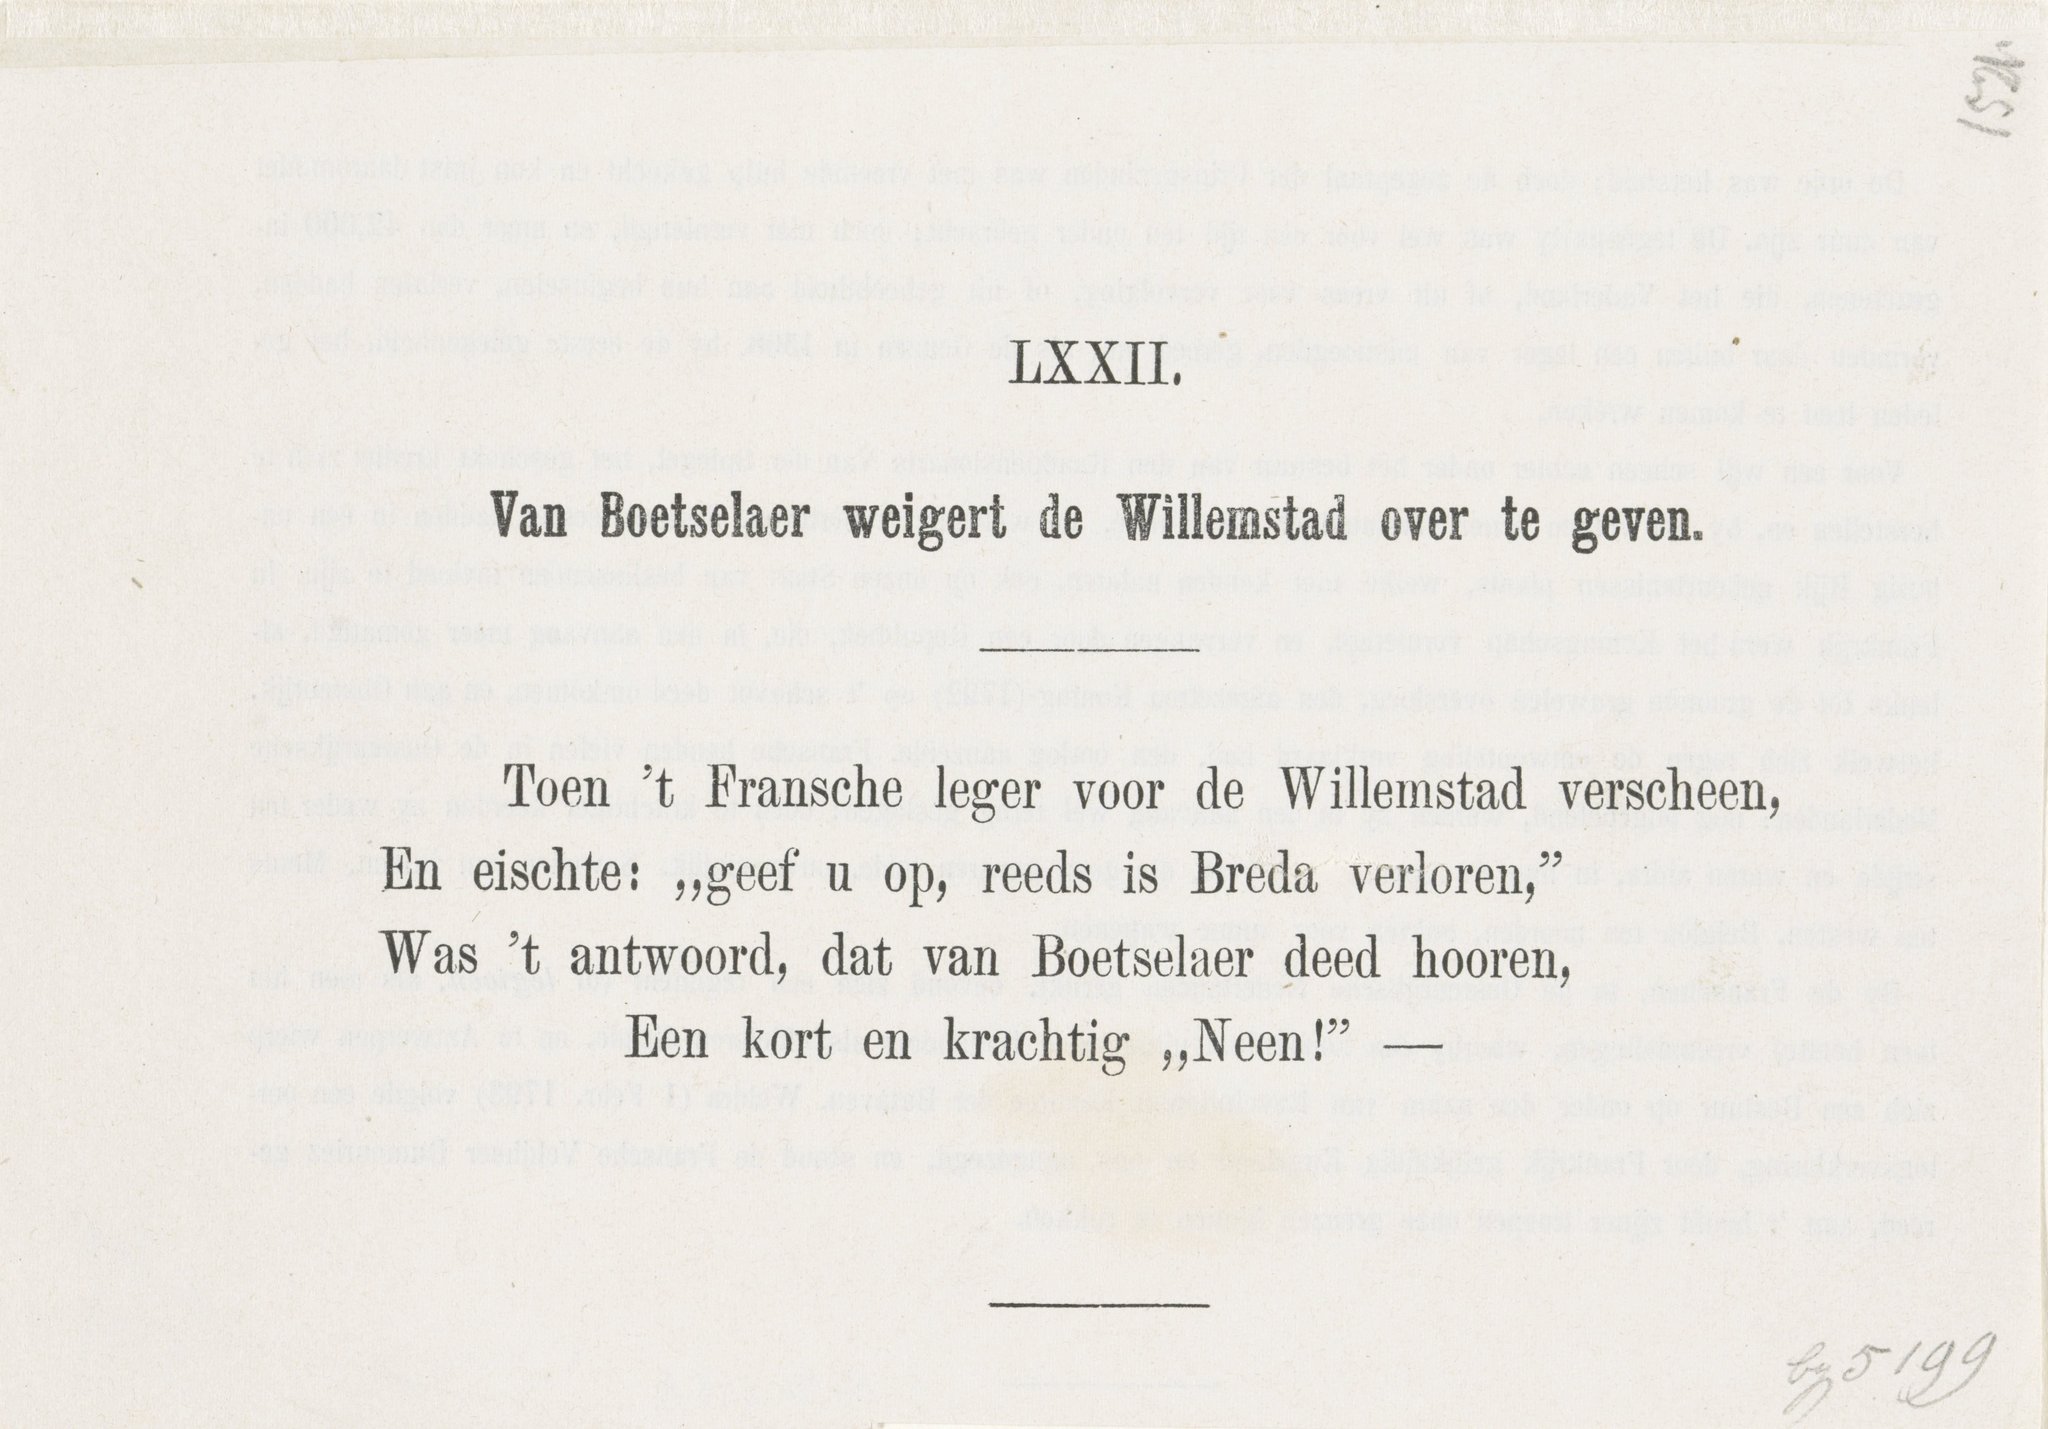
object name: text sheet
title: LXXII. Van Boetselaer weigert de Willemstad over te geven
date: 1853-1861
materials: paper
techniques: letterpress printing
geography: haarlem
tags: the hague, siege, position war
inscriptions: collector's mark: Lugt 2228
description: Tekstblad met een vierreglig vers over de weigering door Carel Baron van Boetzelaer om Willemstad aan de Fransen over te geven, februari-maart 1793. Met tekst op verso.